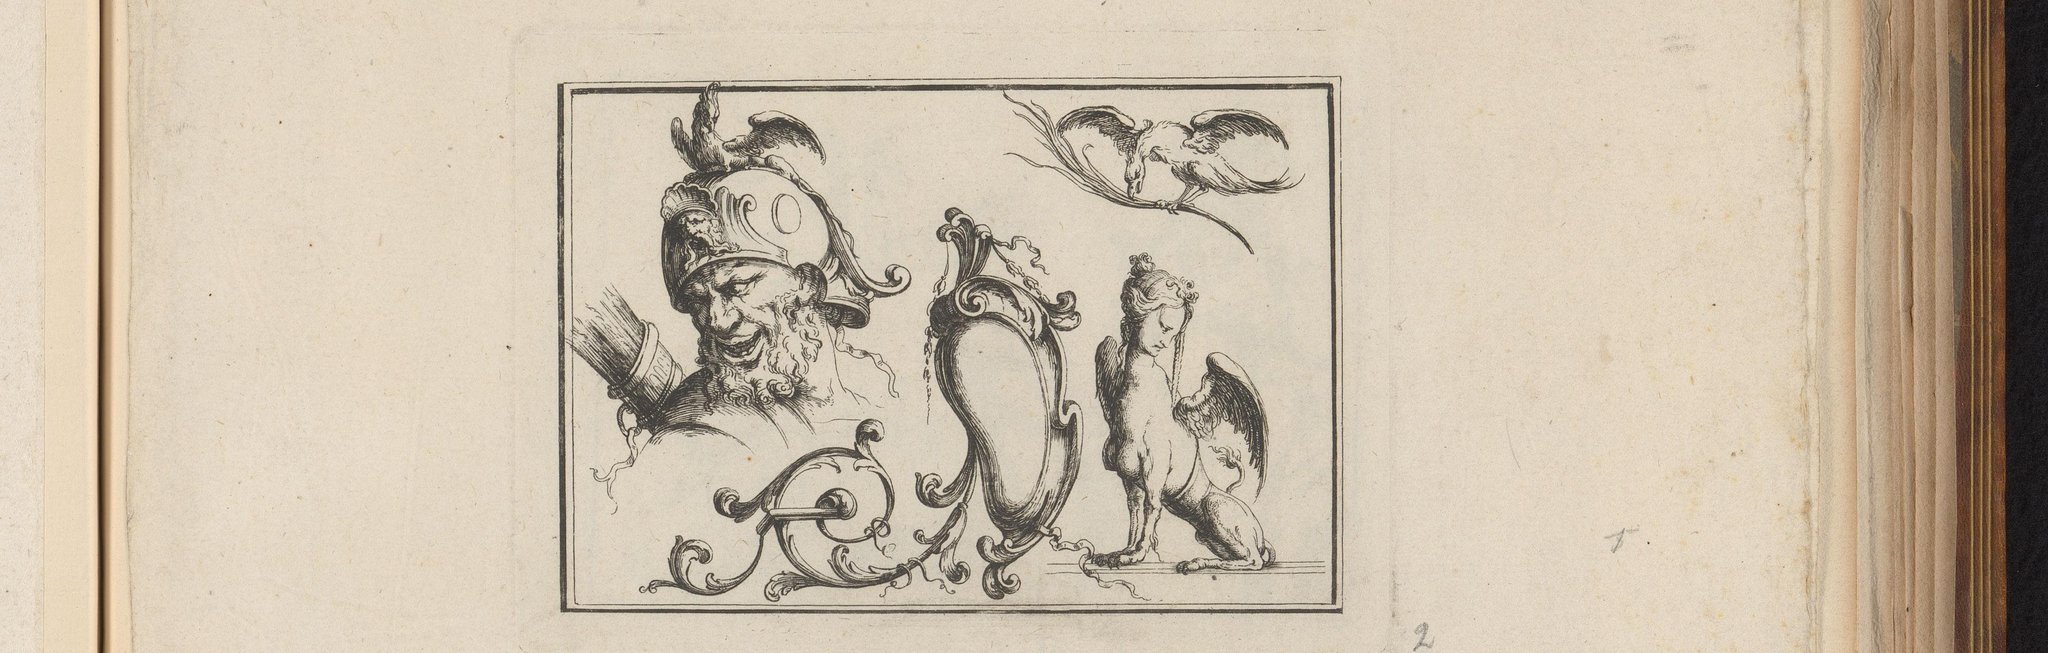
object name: ornament print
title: Ontwerpen voor cartouches en mascarons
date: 1682-1734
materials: paper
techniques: etching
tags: fabulous animals (sometimes wrongly called 'grotesques'); 'mostri' (ripa), ornament ~ cartouche, mask, mascaron ~ ornament, cupids: 'amores', 'amoretti', 'putti'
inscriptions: collector's mark: Lugt 2228, collector's mark: Lugt 2760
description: Prent op onversneden blad met RP-P-1964-85. Prent maakt deel uit van een album.